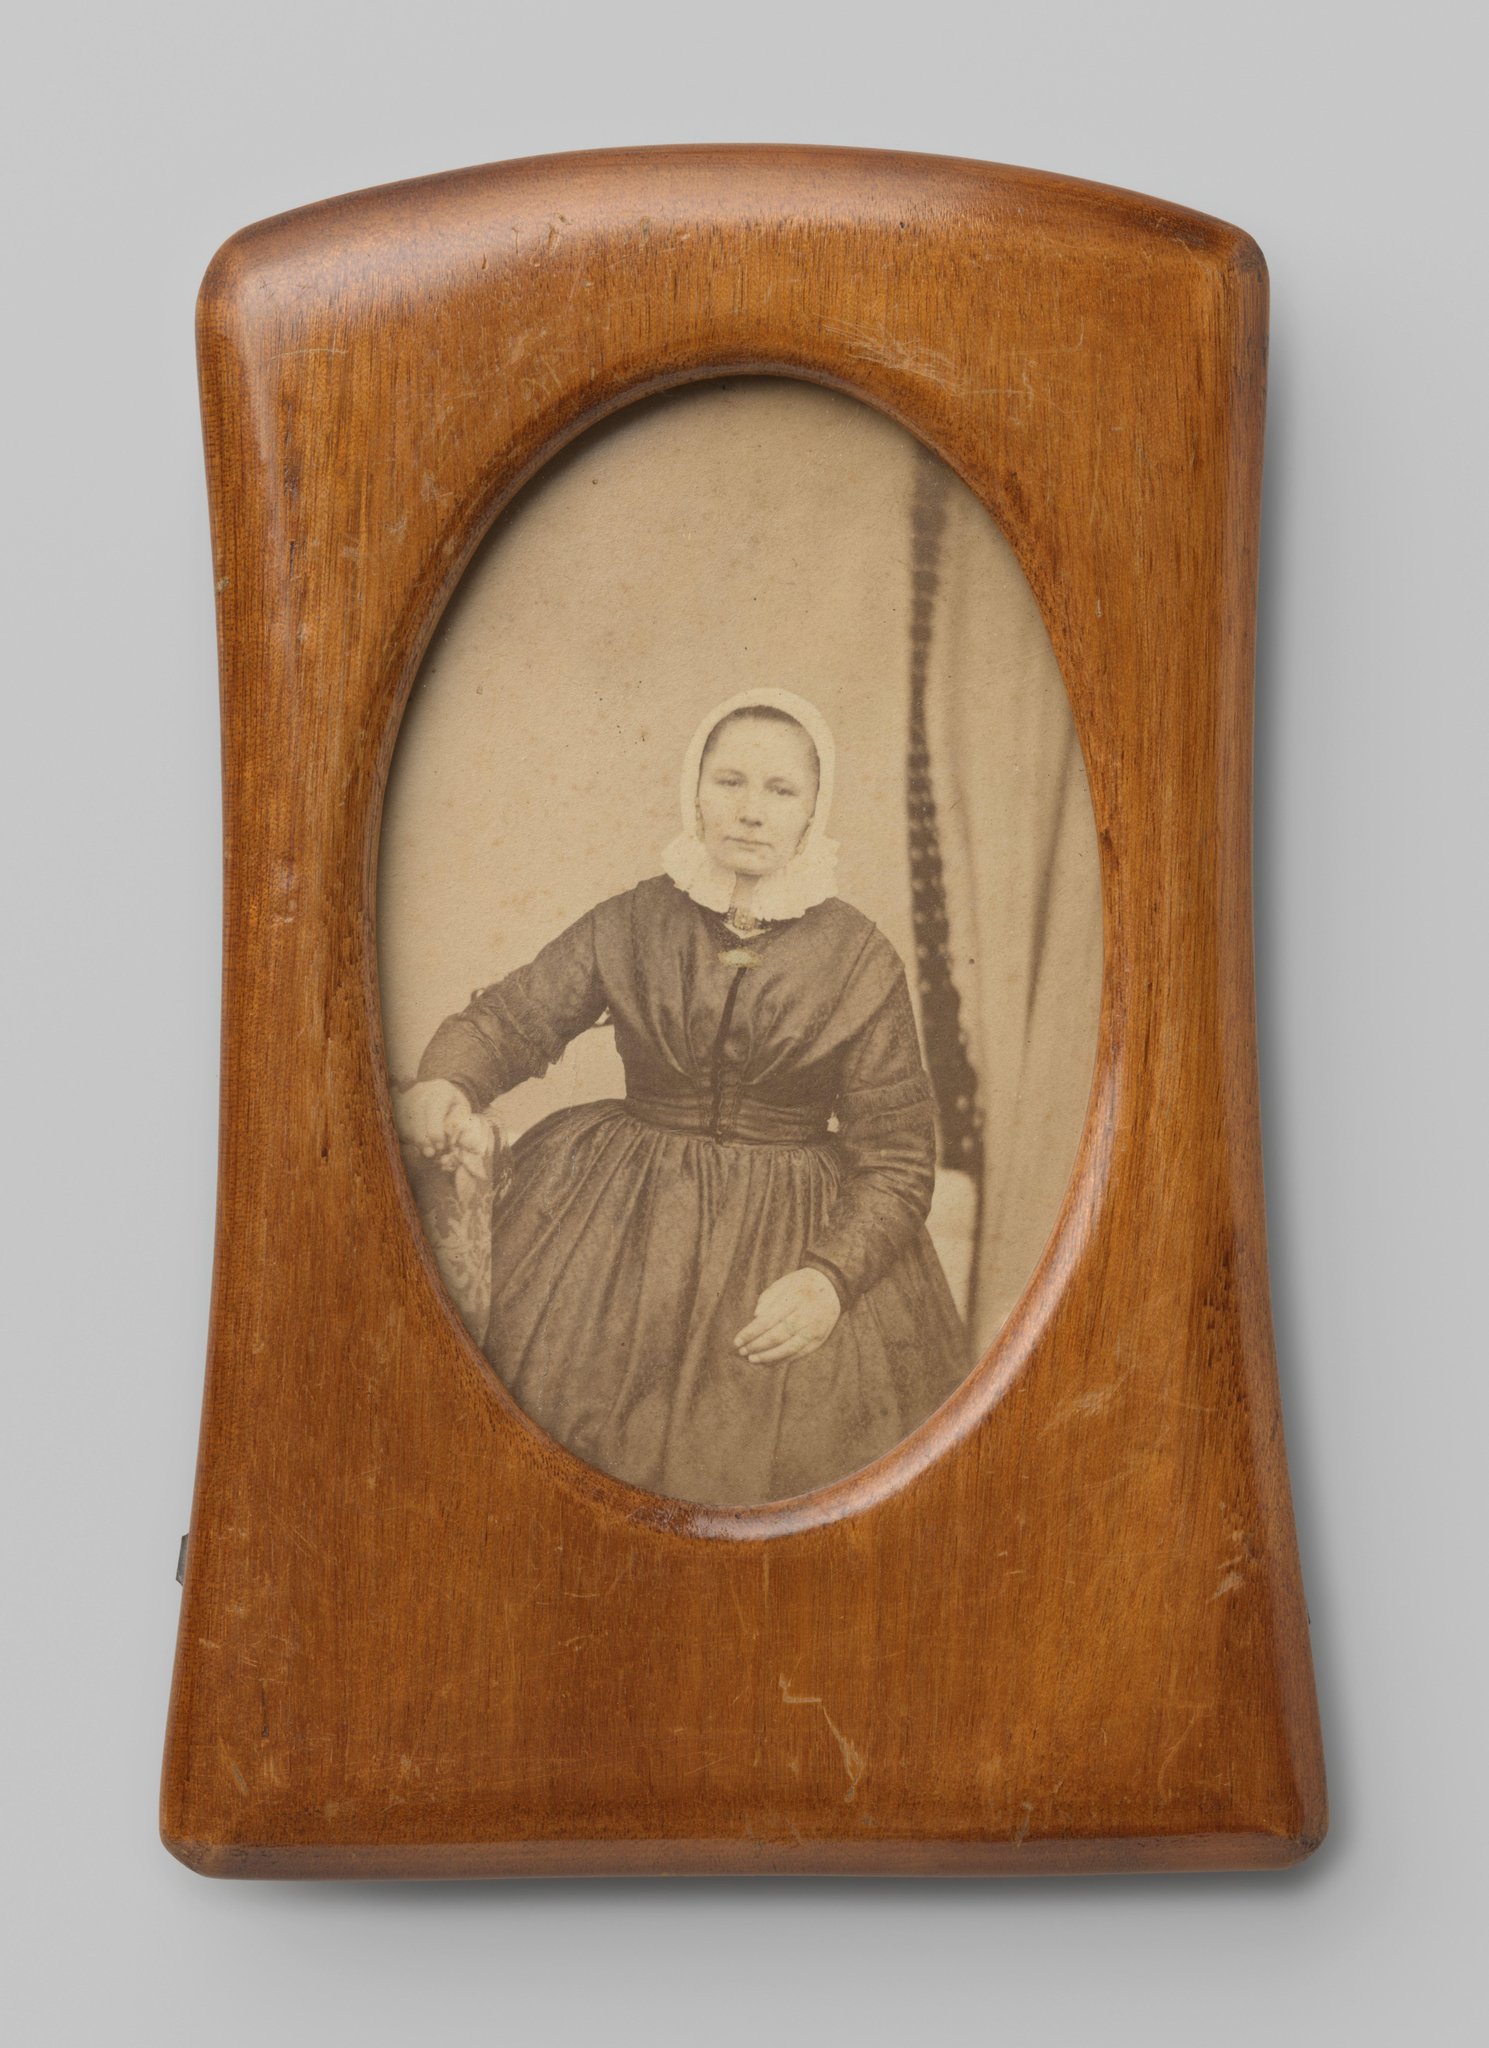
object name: frame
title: Portret van een onbekende zittende vrouw met muts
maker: Anonymous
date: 1870-1900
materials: cardboard, glass, metal, paper, textile, wood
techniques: albumen print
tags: sitting figure, head-gear: cap, anonymous historical person portrayed - bb - woman